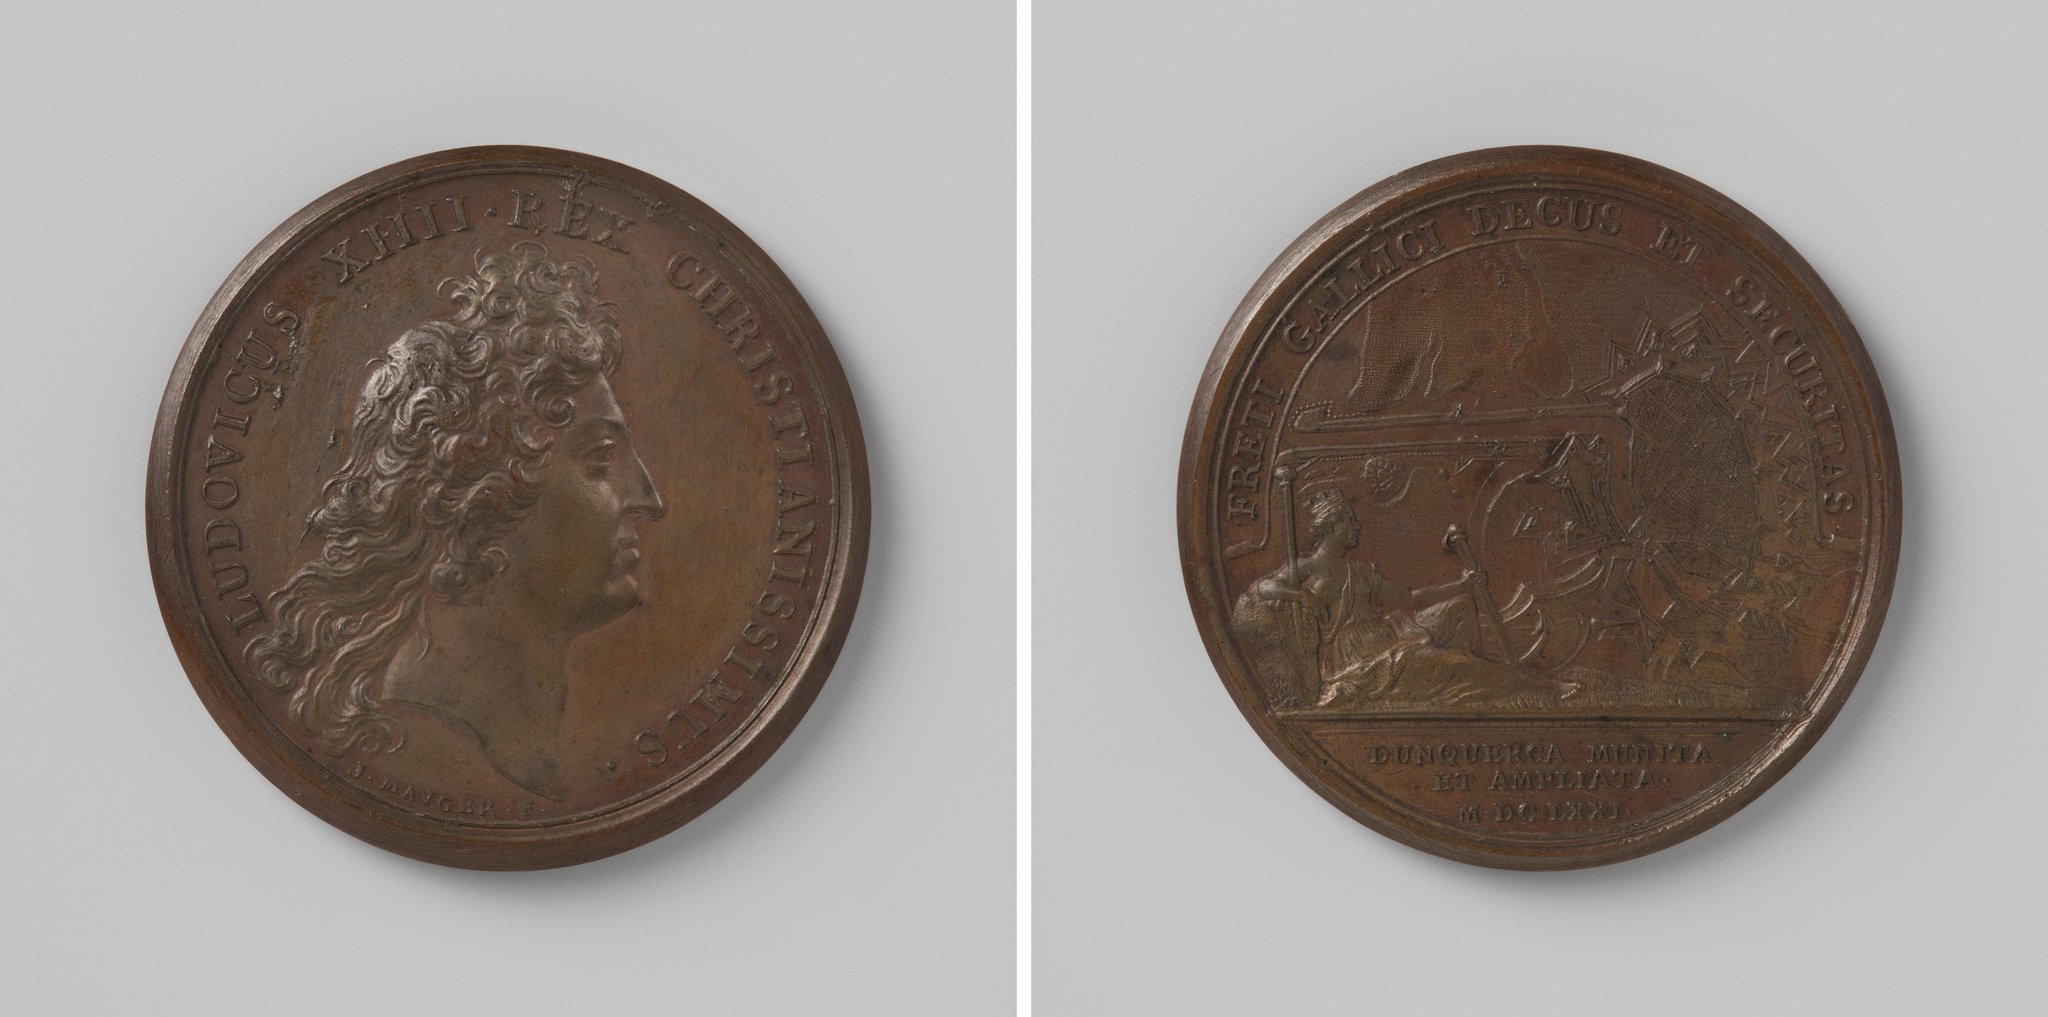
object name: history medal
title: Duinkerken versterkt en vergroot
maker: jean mauger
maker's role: medailleur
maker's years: 1648-1722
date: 1699-1703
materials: bronze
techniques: striking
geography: paris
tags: lodewijk xiv (koning van frankrijk)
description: Bronzen penning. Voorzijde: borststuk jongeman (Lodewijk XIV) binnen omschrift. Keerzijde: gekroonde Duinkerken met scheepsroer en anker gezeten naast plattegrond van stad binnen omschrift